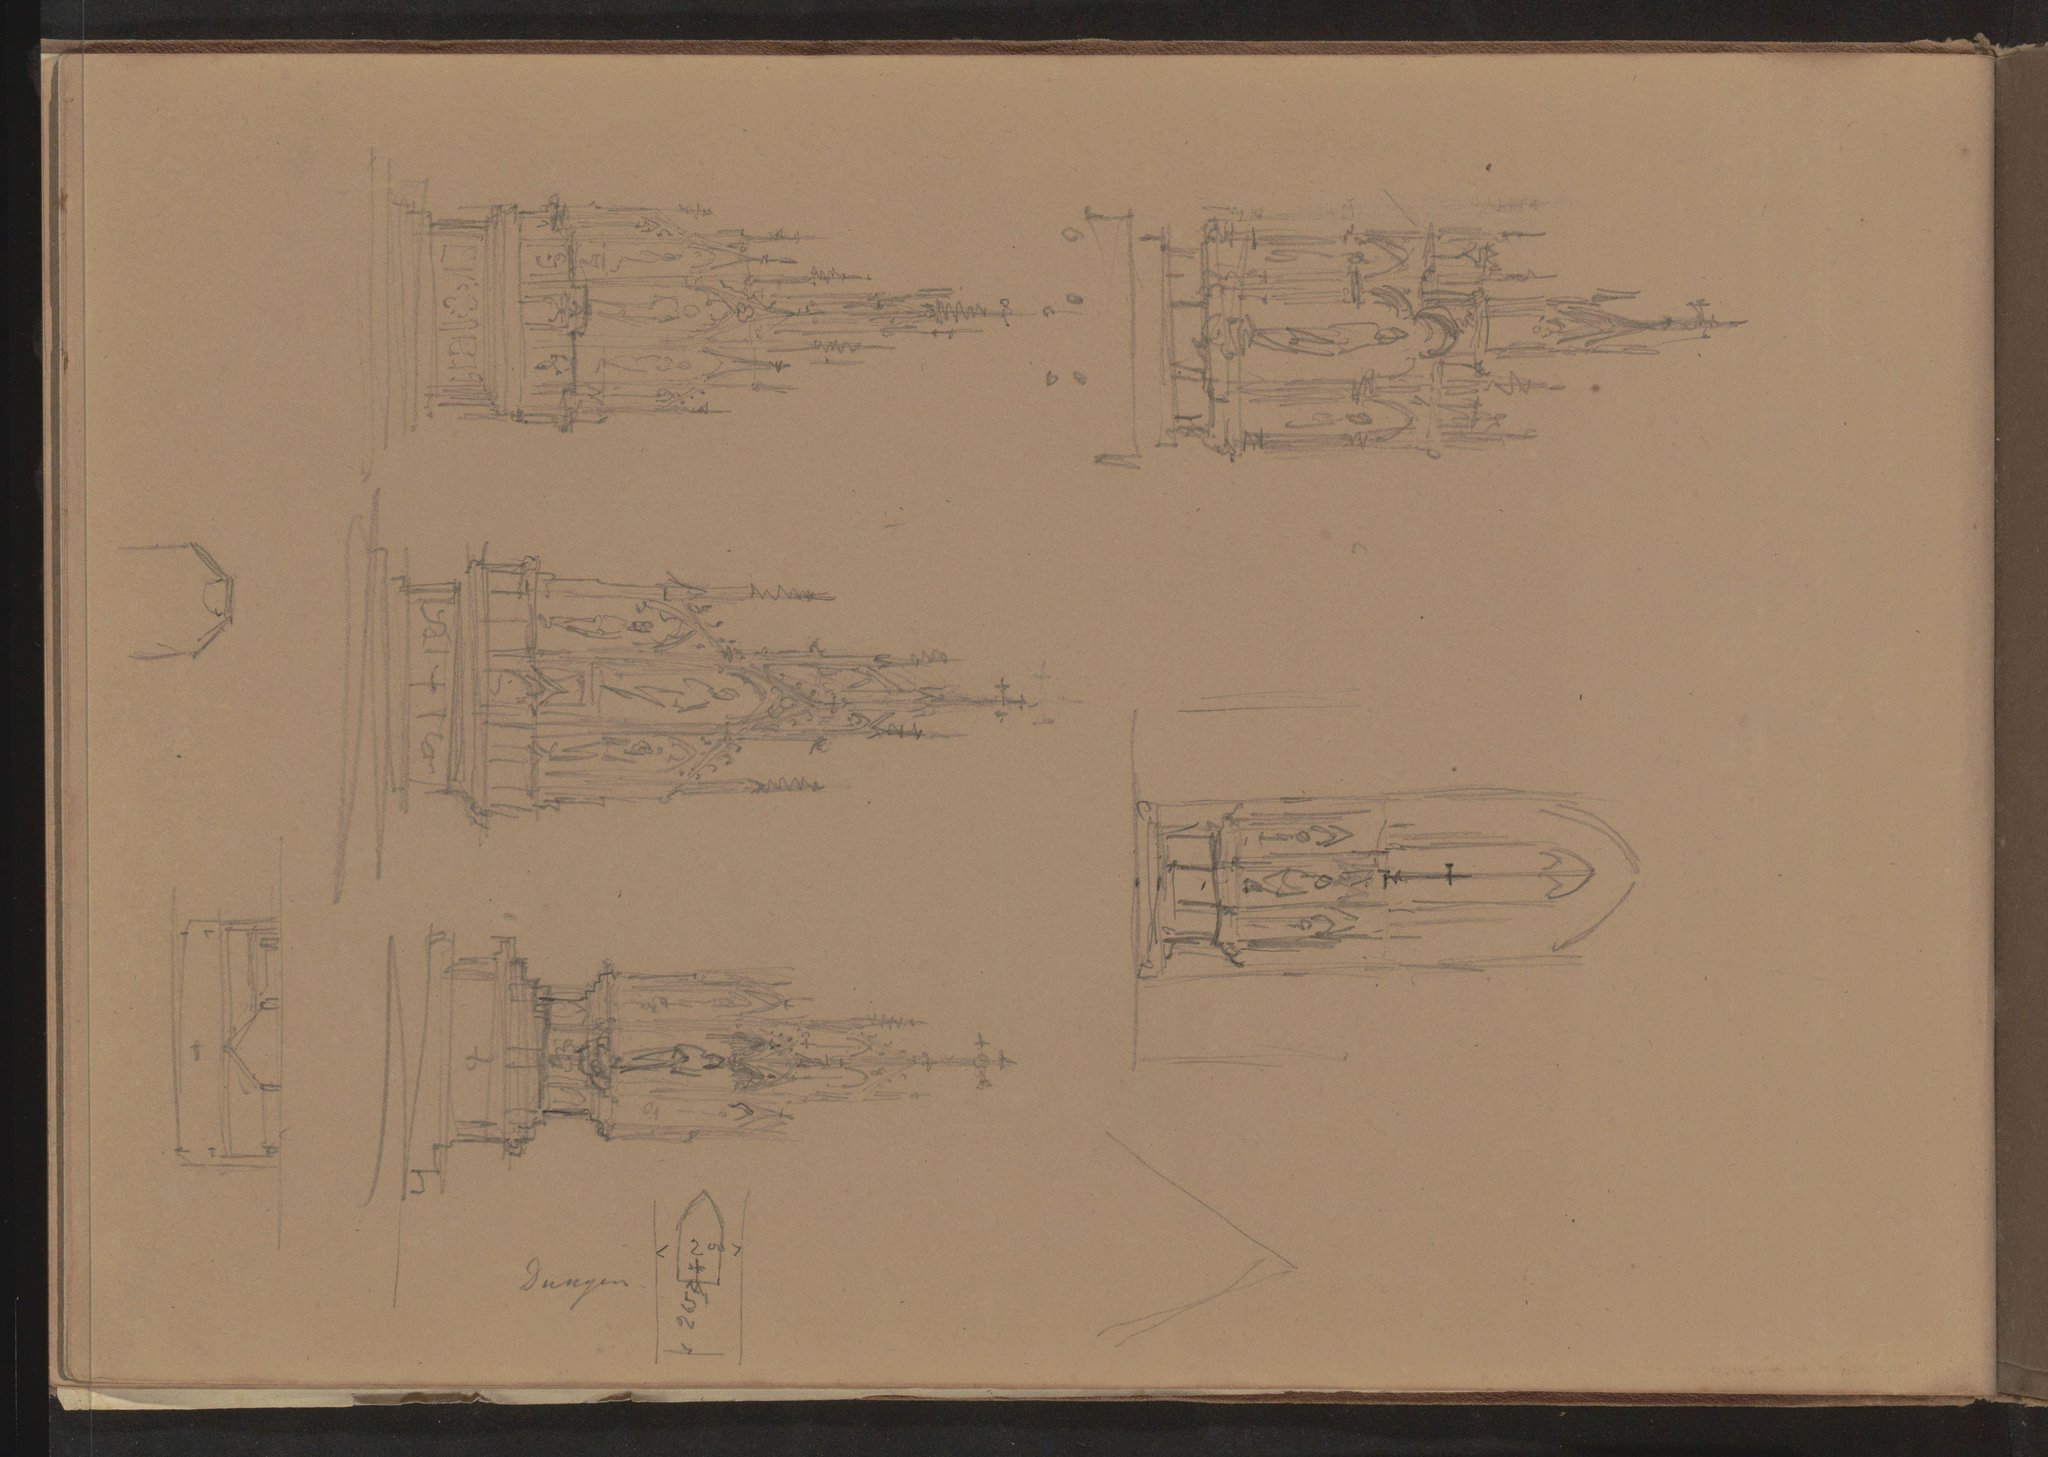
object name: sketchbook leaf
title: Altaren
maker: pierre joseph hubert cuypers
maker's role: draughtsman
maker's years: 1827-1921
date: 1837-1921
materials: paper, pencil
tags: altar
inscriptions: annotation: ‘Dungen/ [...]’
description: Blad 13 verso uit een schetsboek met 23 bladen.